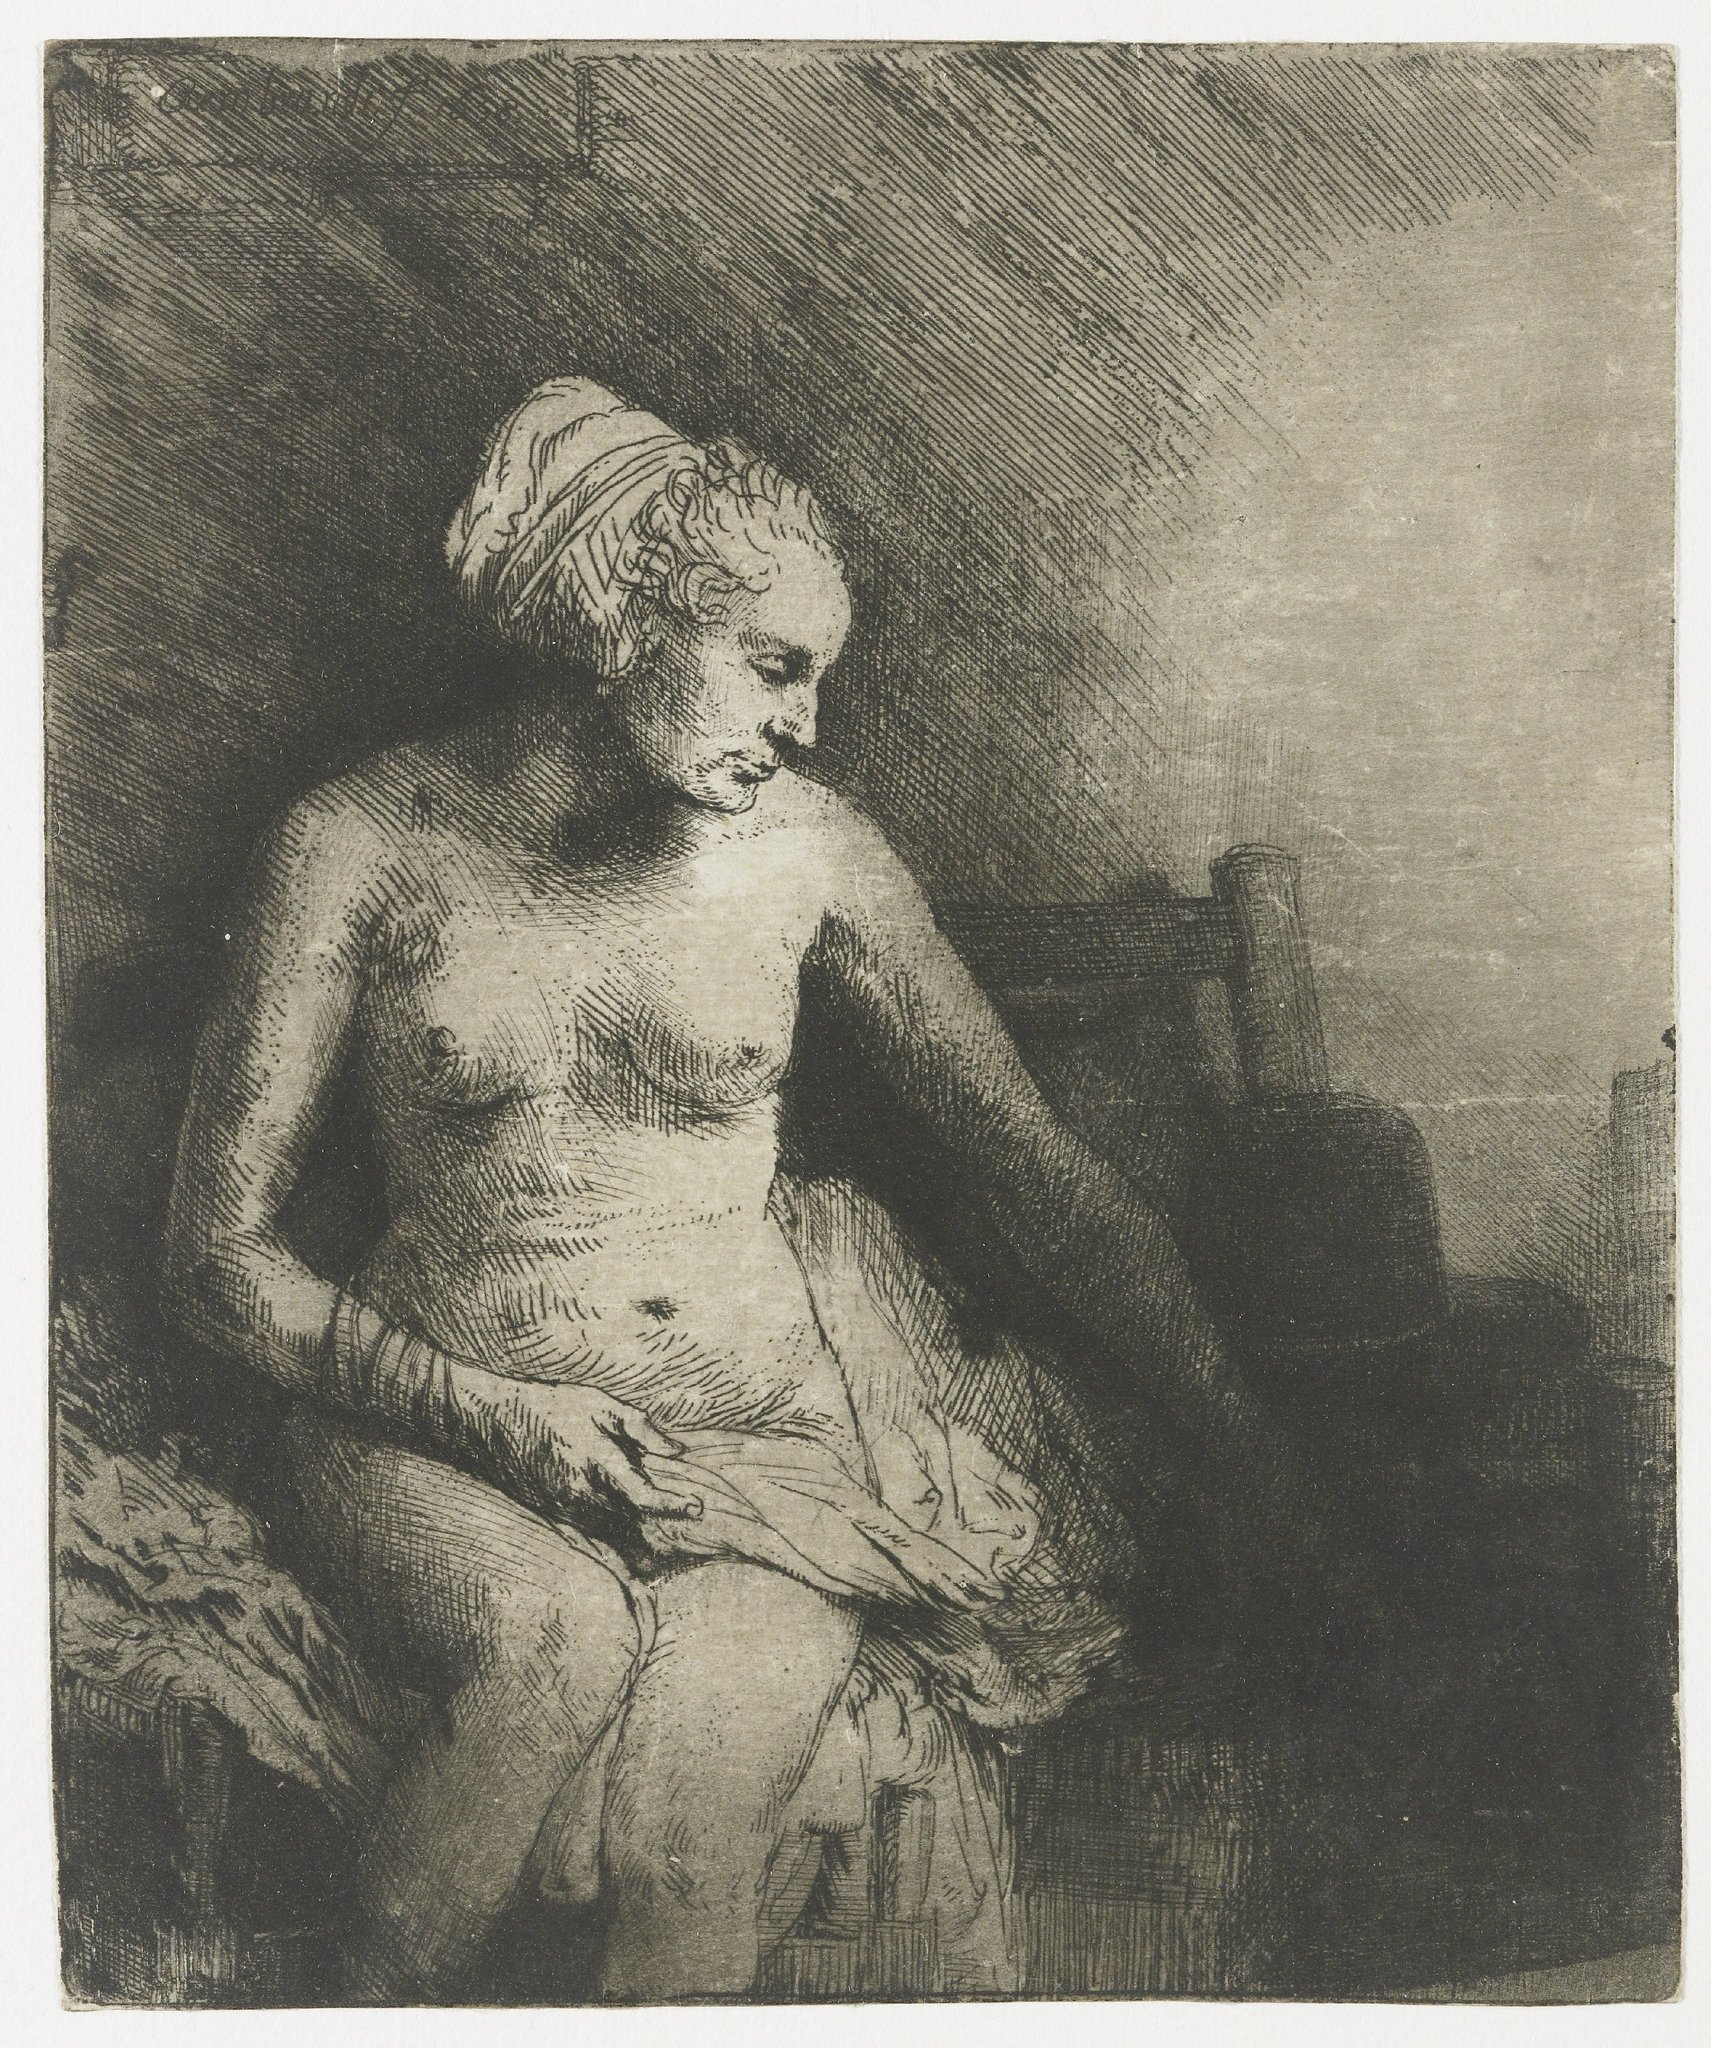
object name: print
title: Woman at the bath with a hat beside her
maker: rembrandt van rijn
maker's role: draughtsman, painter, print maker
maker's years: 1606-1669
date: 1658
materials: paper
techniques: drypoint, etching, intaglio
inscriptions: signature and date: ‘Rembrandt f. 1658’, collector's mark: Lugt 240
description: According to the classicizing rules of art an artist had to pick what was most beautiful in nature and represent it following models from classical or famous masters, such as Raphael. Rembrandt’s idea of what was ‘picturesque’ however was different. This somewhat older woman at the bath in no way adheres to the classical ideal of beauty. Rembrandt portrayed her naturalistically: huddled, with her neck stretched forward, and a man’s hat beside her.